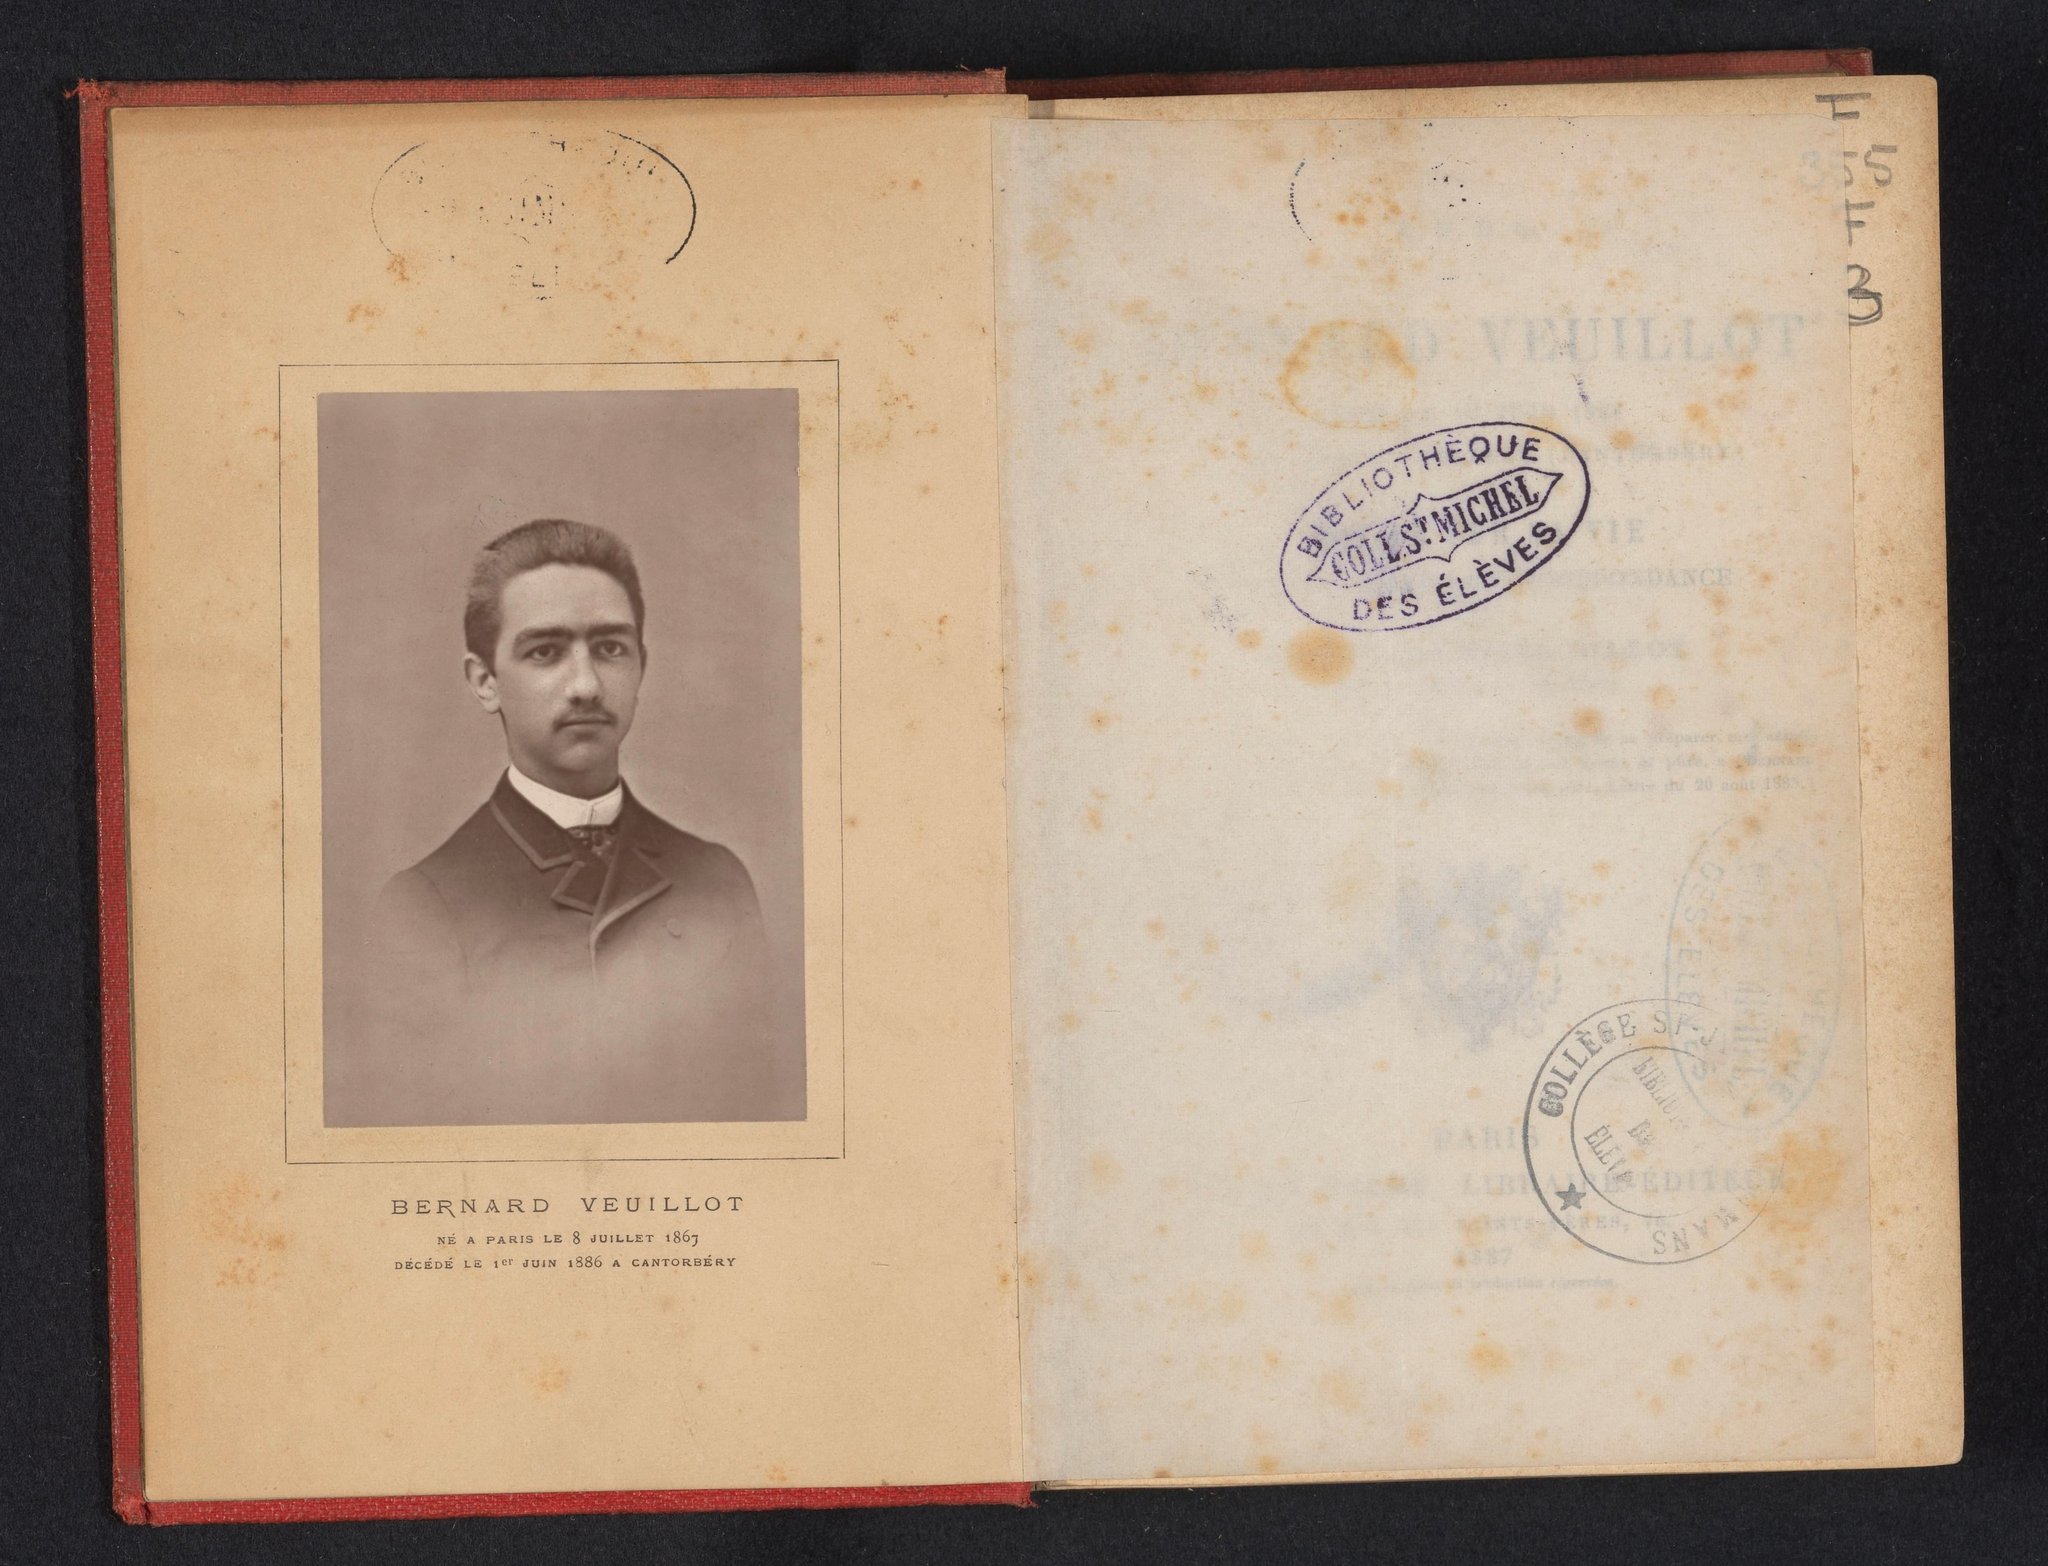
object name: page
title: Portret van Bernard Veuillot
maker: Anonymous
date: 1880-1886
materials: paper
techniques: woodburytype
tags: clergyman, adult man